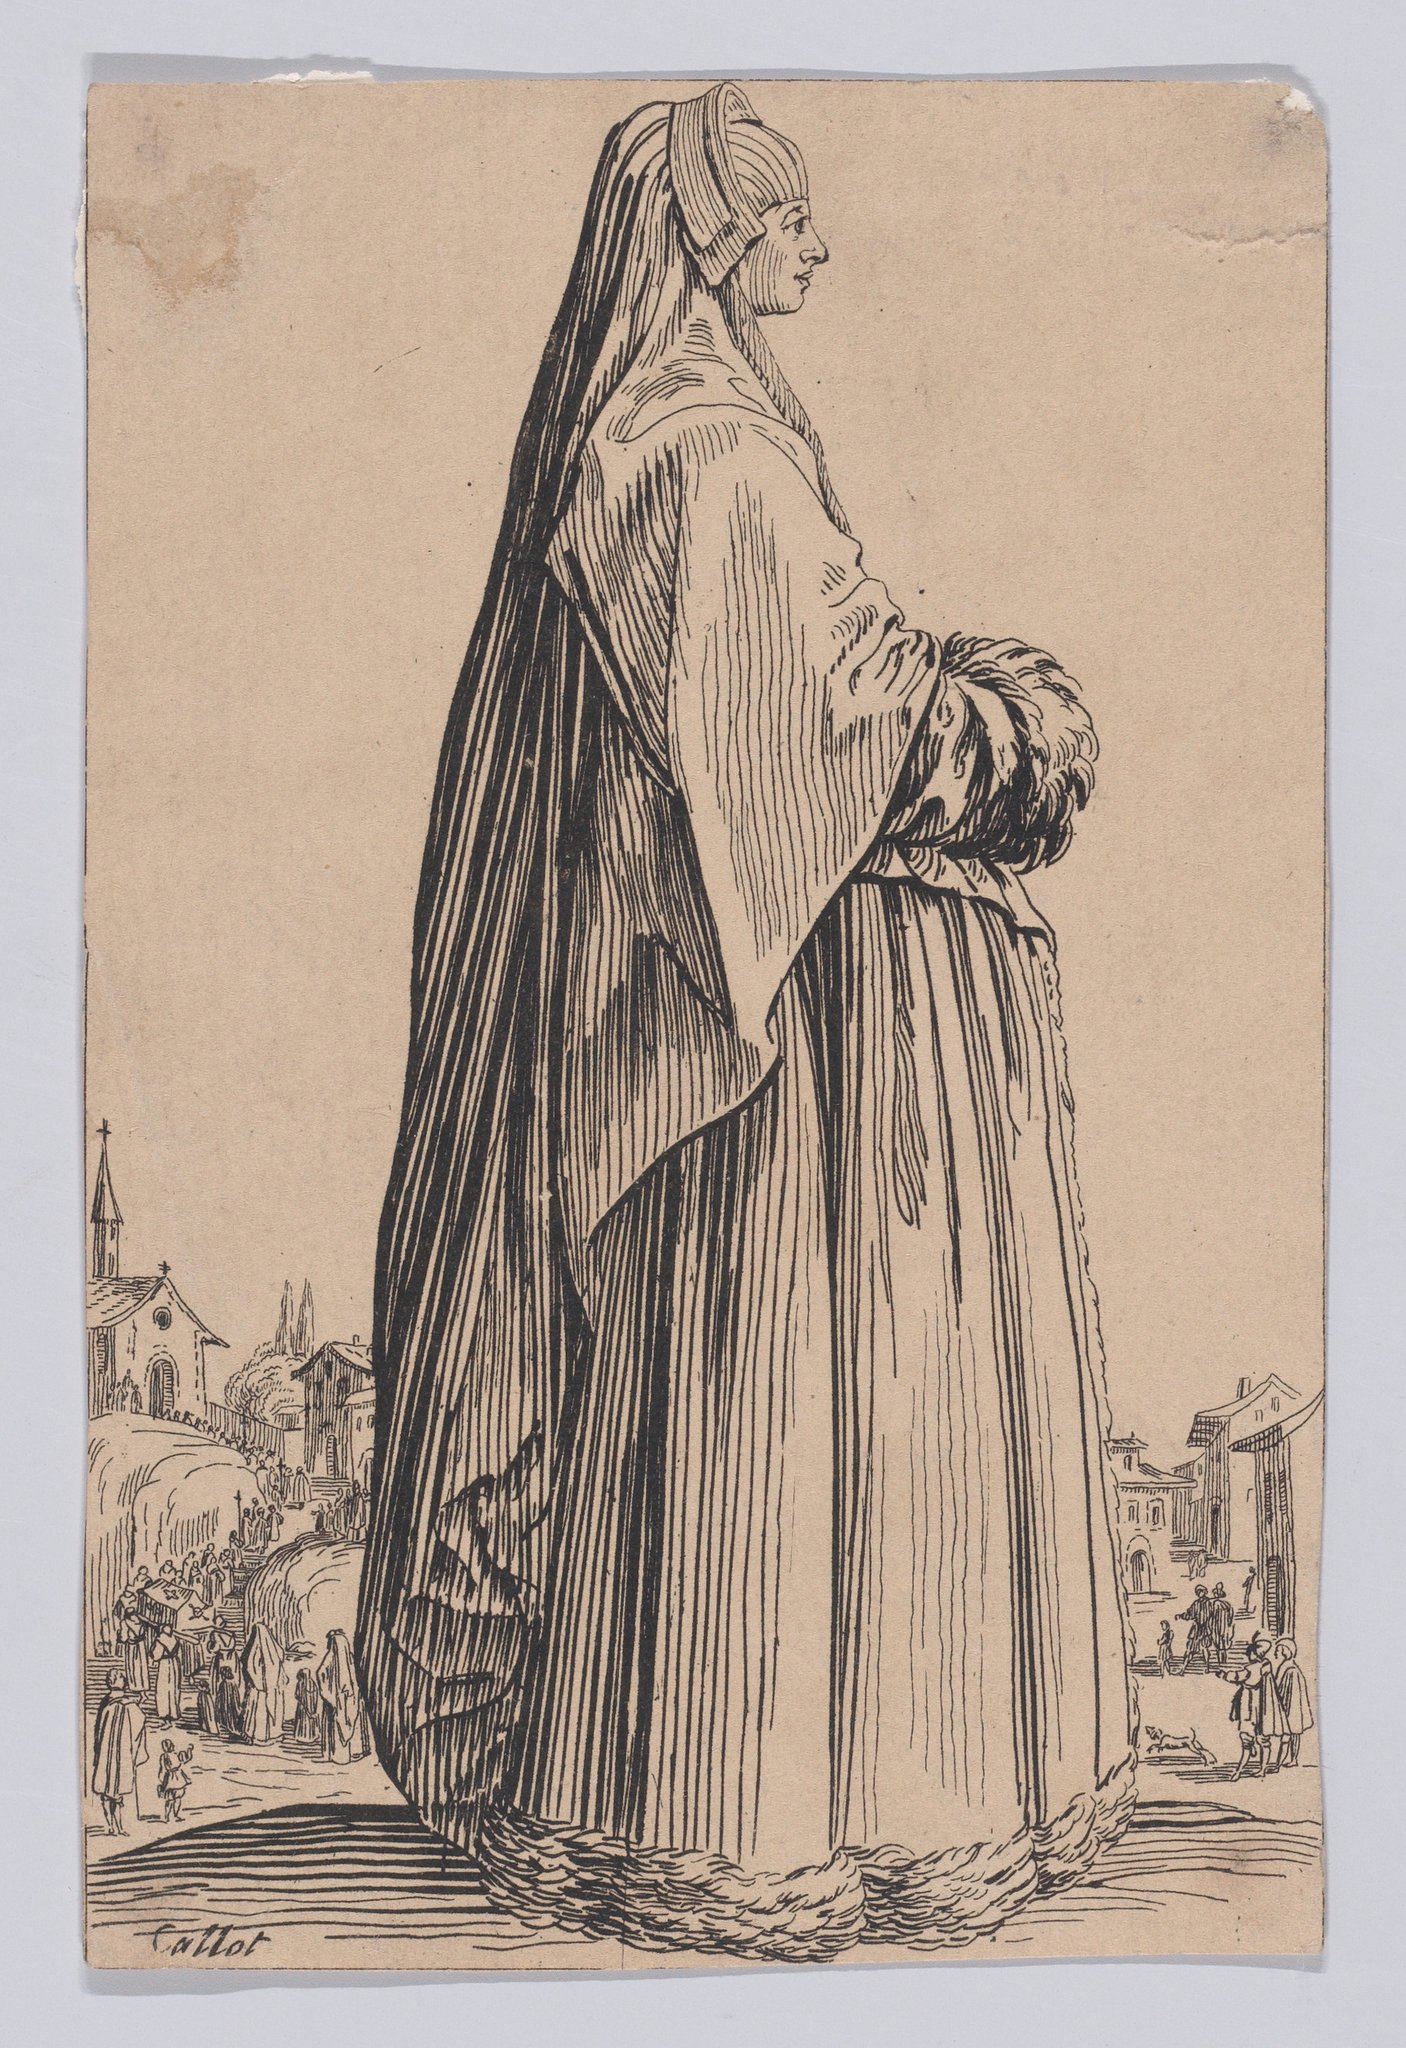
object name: print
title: Copy of La Dame Coiffée d'un Grand Voile et a la Robe Bordée de Fourrures (The Lady Wearing a Long Veil and a Fur-Lined Robe), from "La Noblesse" (The Nobility)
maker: Anonymous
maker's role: artist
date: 1601-1700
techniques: etching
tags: women